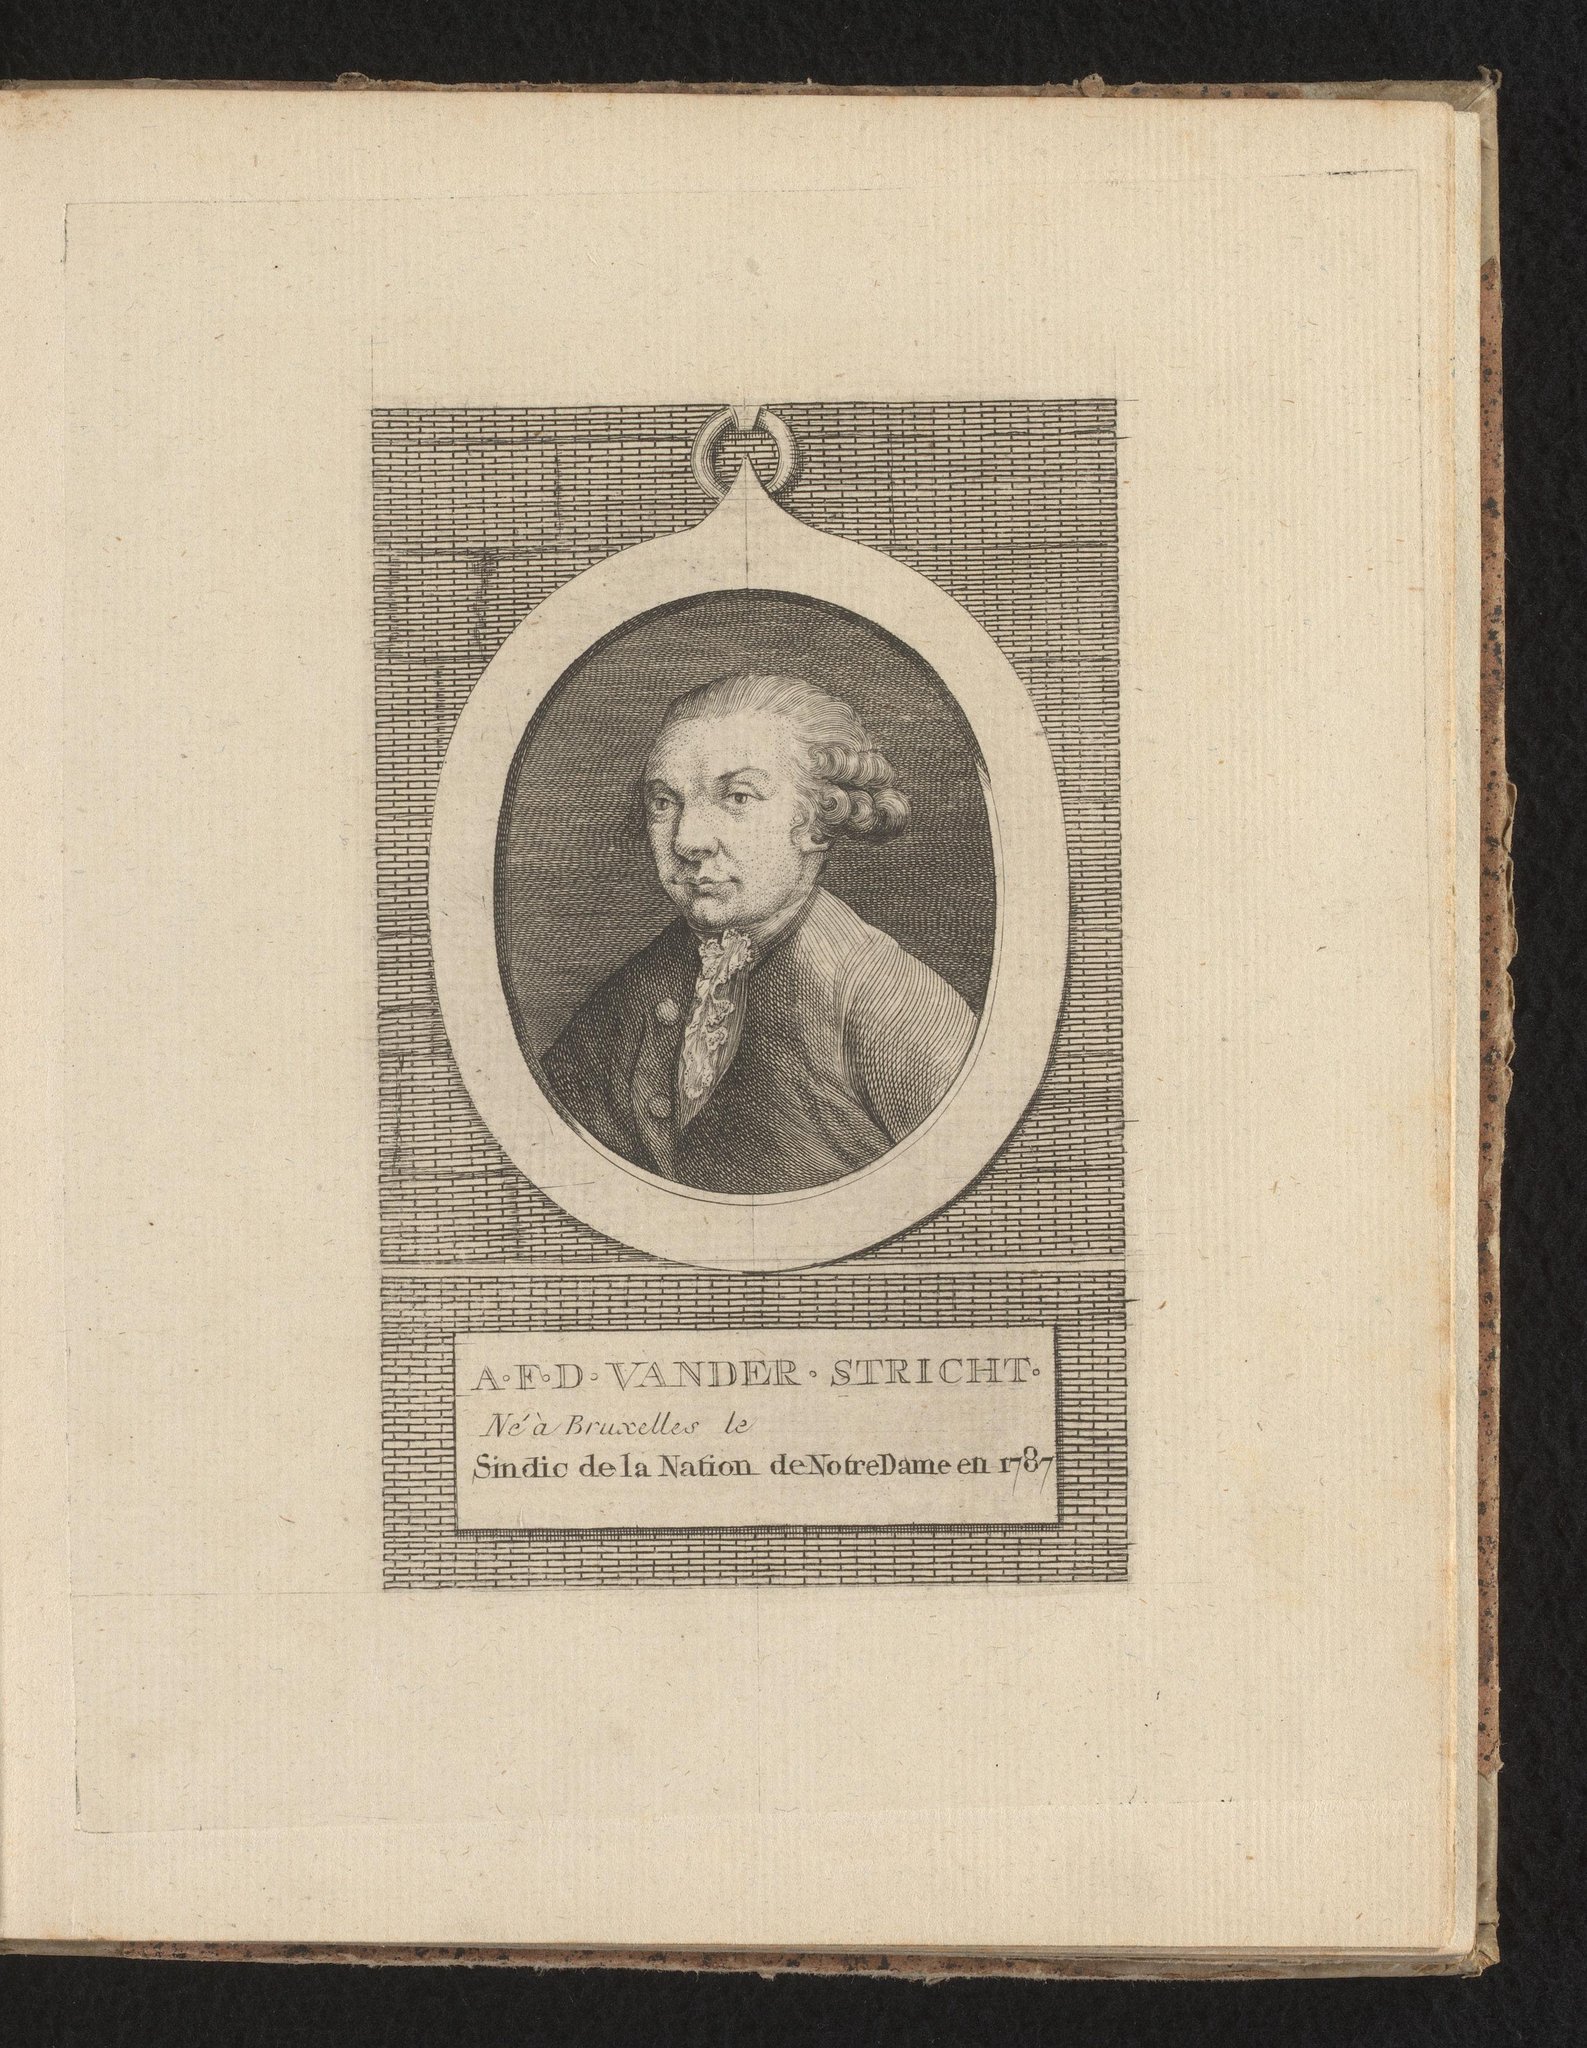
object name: print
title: A.F.D. Vander Stricht. Né à Bruxelles le (...) Sindic de la Nation de Notre Dame en 1787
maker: j.f. de la rue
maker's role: print maker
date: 1787-1790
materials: paper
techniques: engraving, etching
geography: southern netherlands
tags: brussels, brabant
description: Portret van A.F.D. vander Stricht, in 1787 vertegenwoordiger van Tongre-Notre-Dame. Onderdeel van de gebundelde verzameling prenten betrekking hebbend op de gebeurtenissen van de Brabantse Omwenteling en de periode 1787-1790.